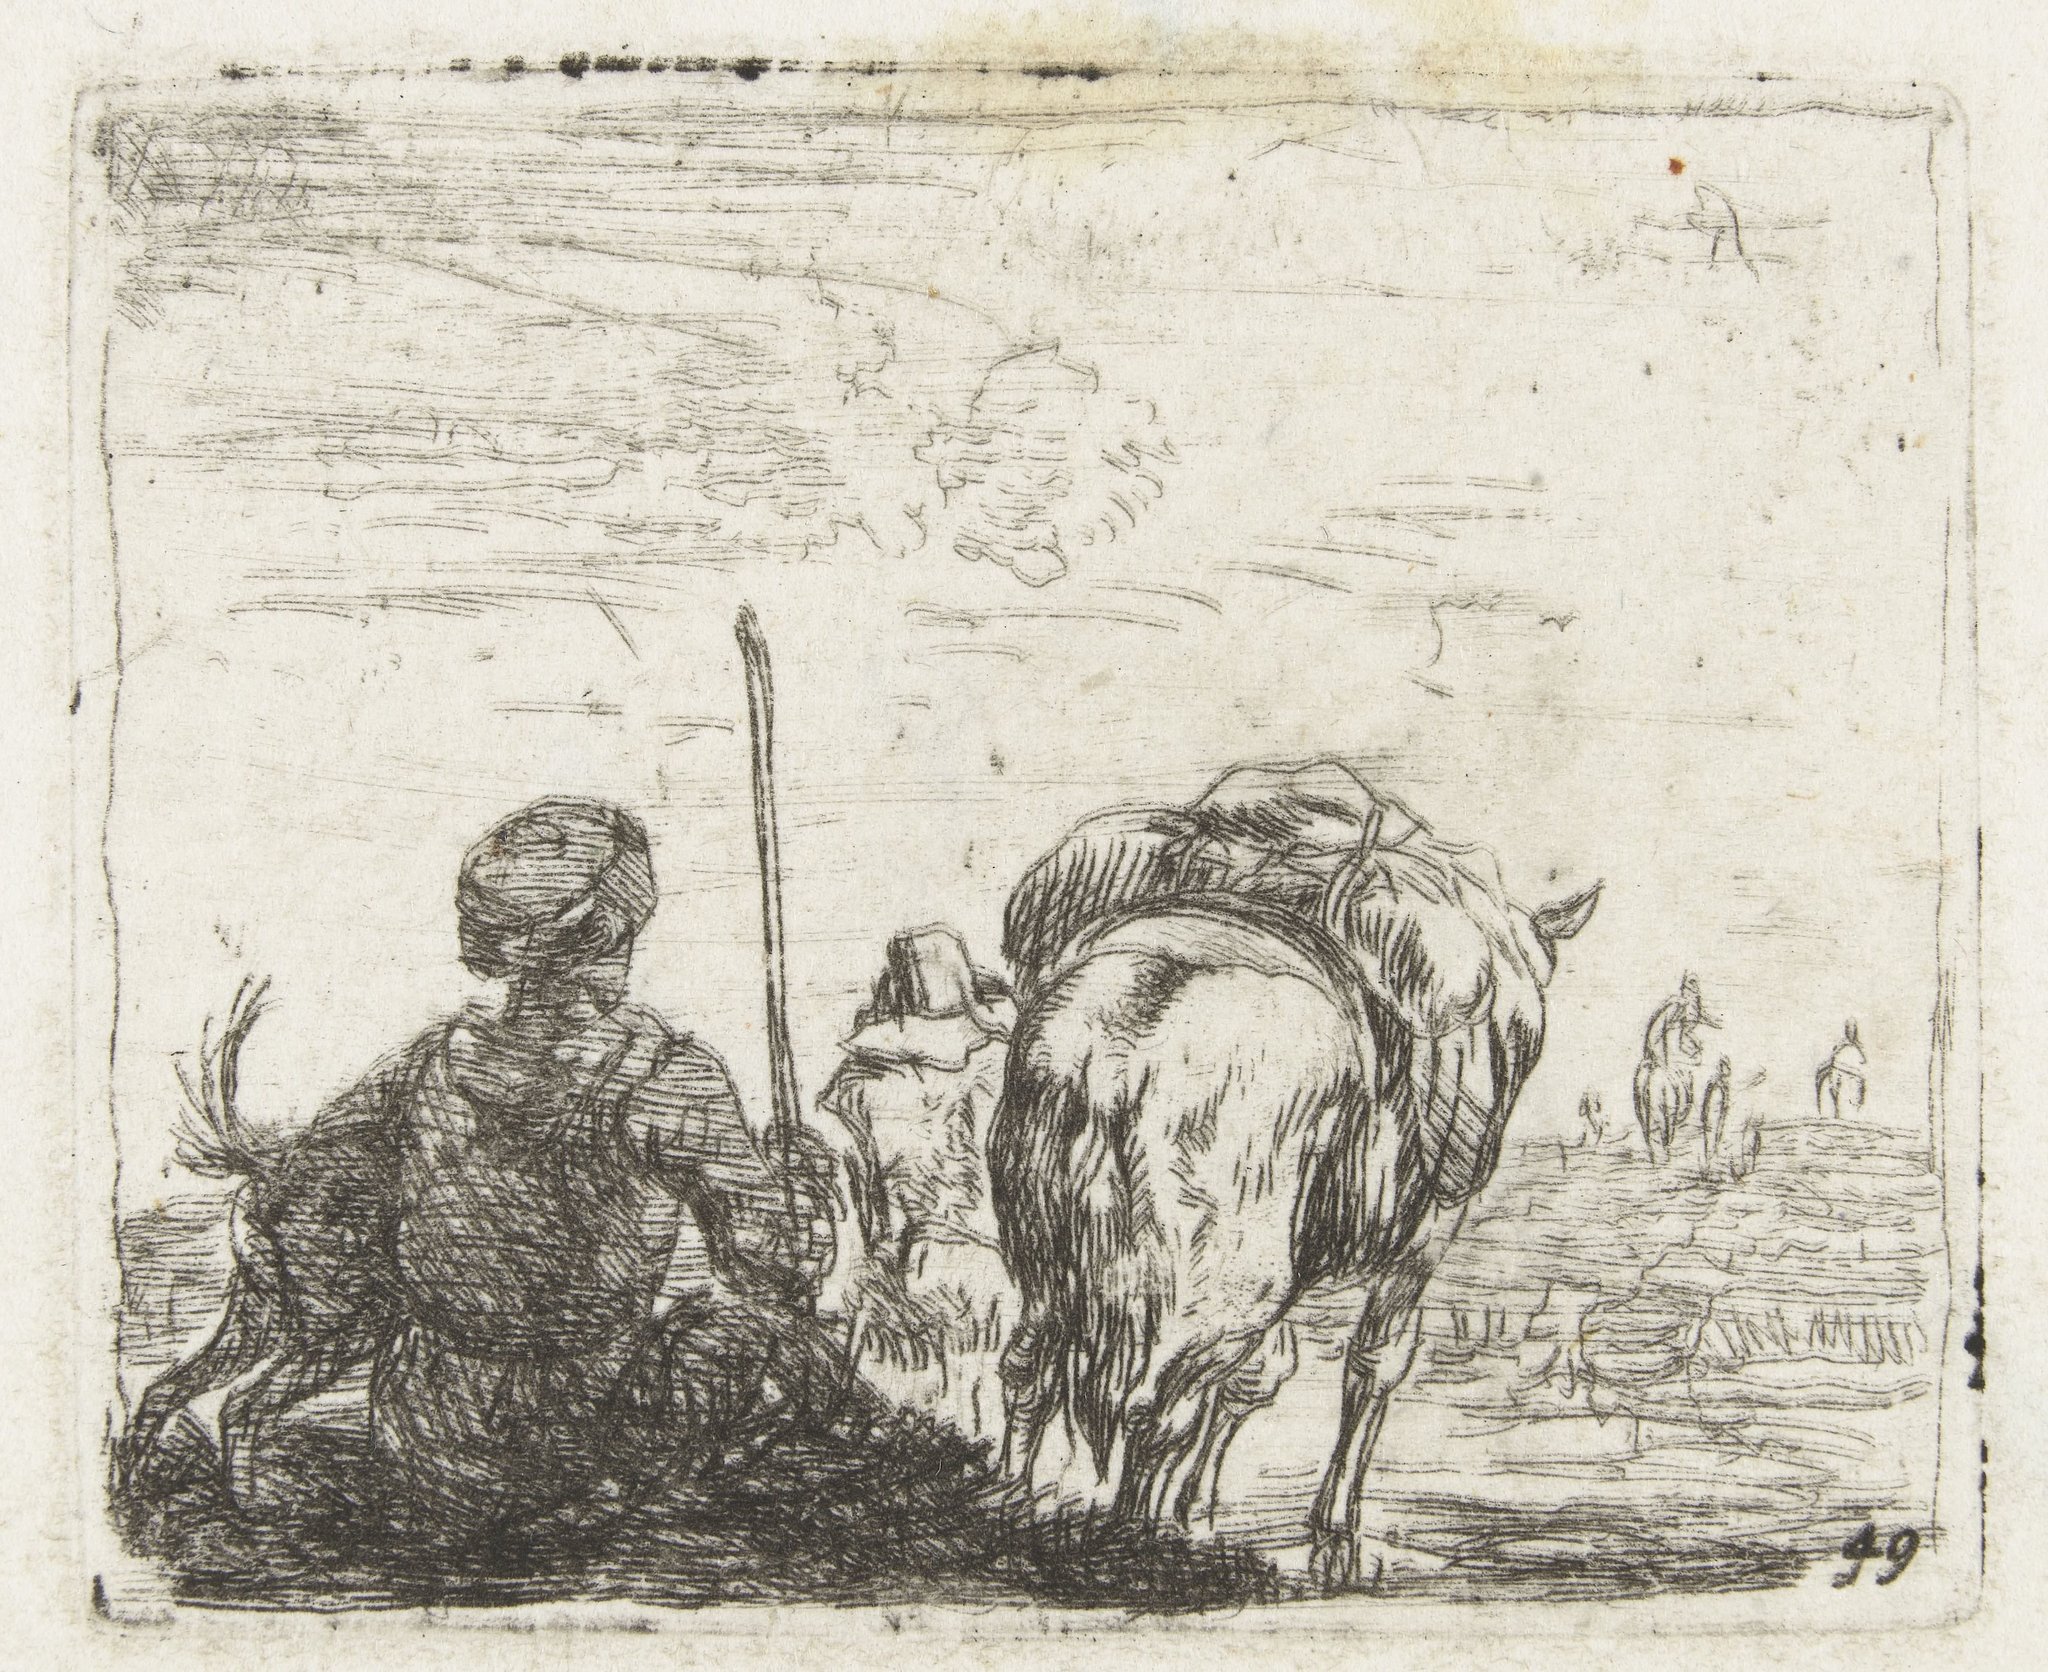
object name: print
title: Kleine landschappen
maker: karel du jardin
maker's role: draughtsman, painter, print maker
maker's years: 1626-1678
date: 1652-1659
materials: paper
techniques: etching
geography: netherlands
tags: herding, herdsman, herdswoman, shepherd, shepherdess, cowherd, etc., horse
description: Maakt deel uit van blad met acht kleine etsen